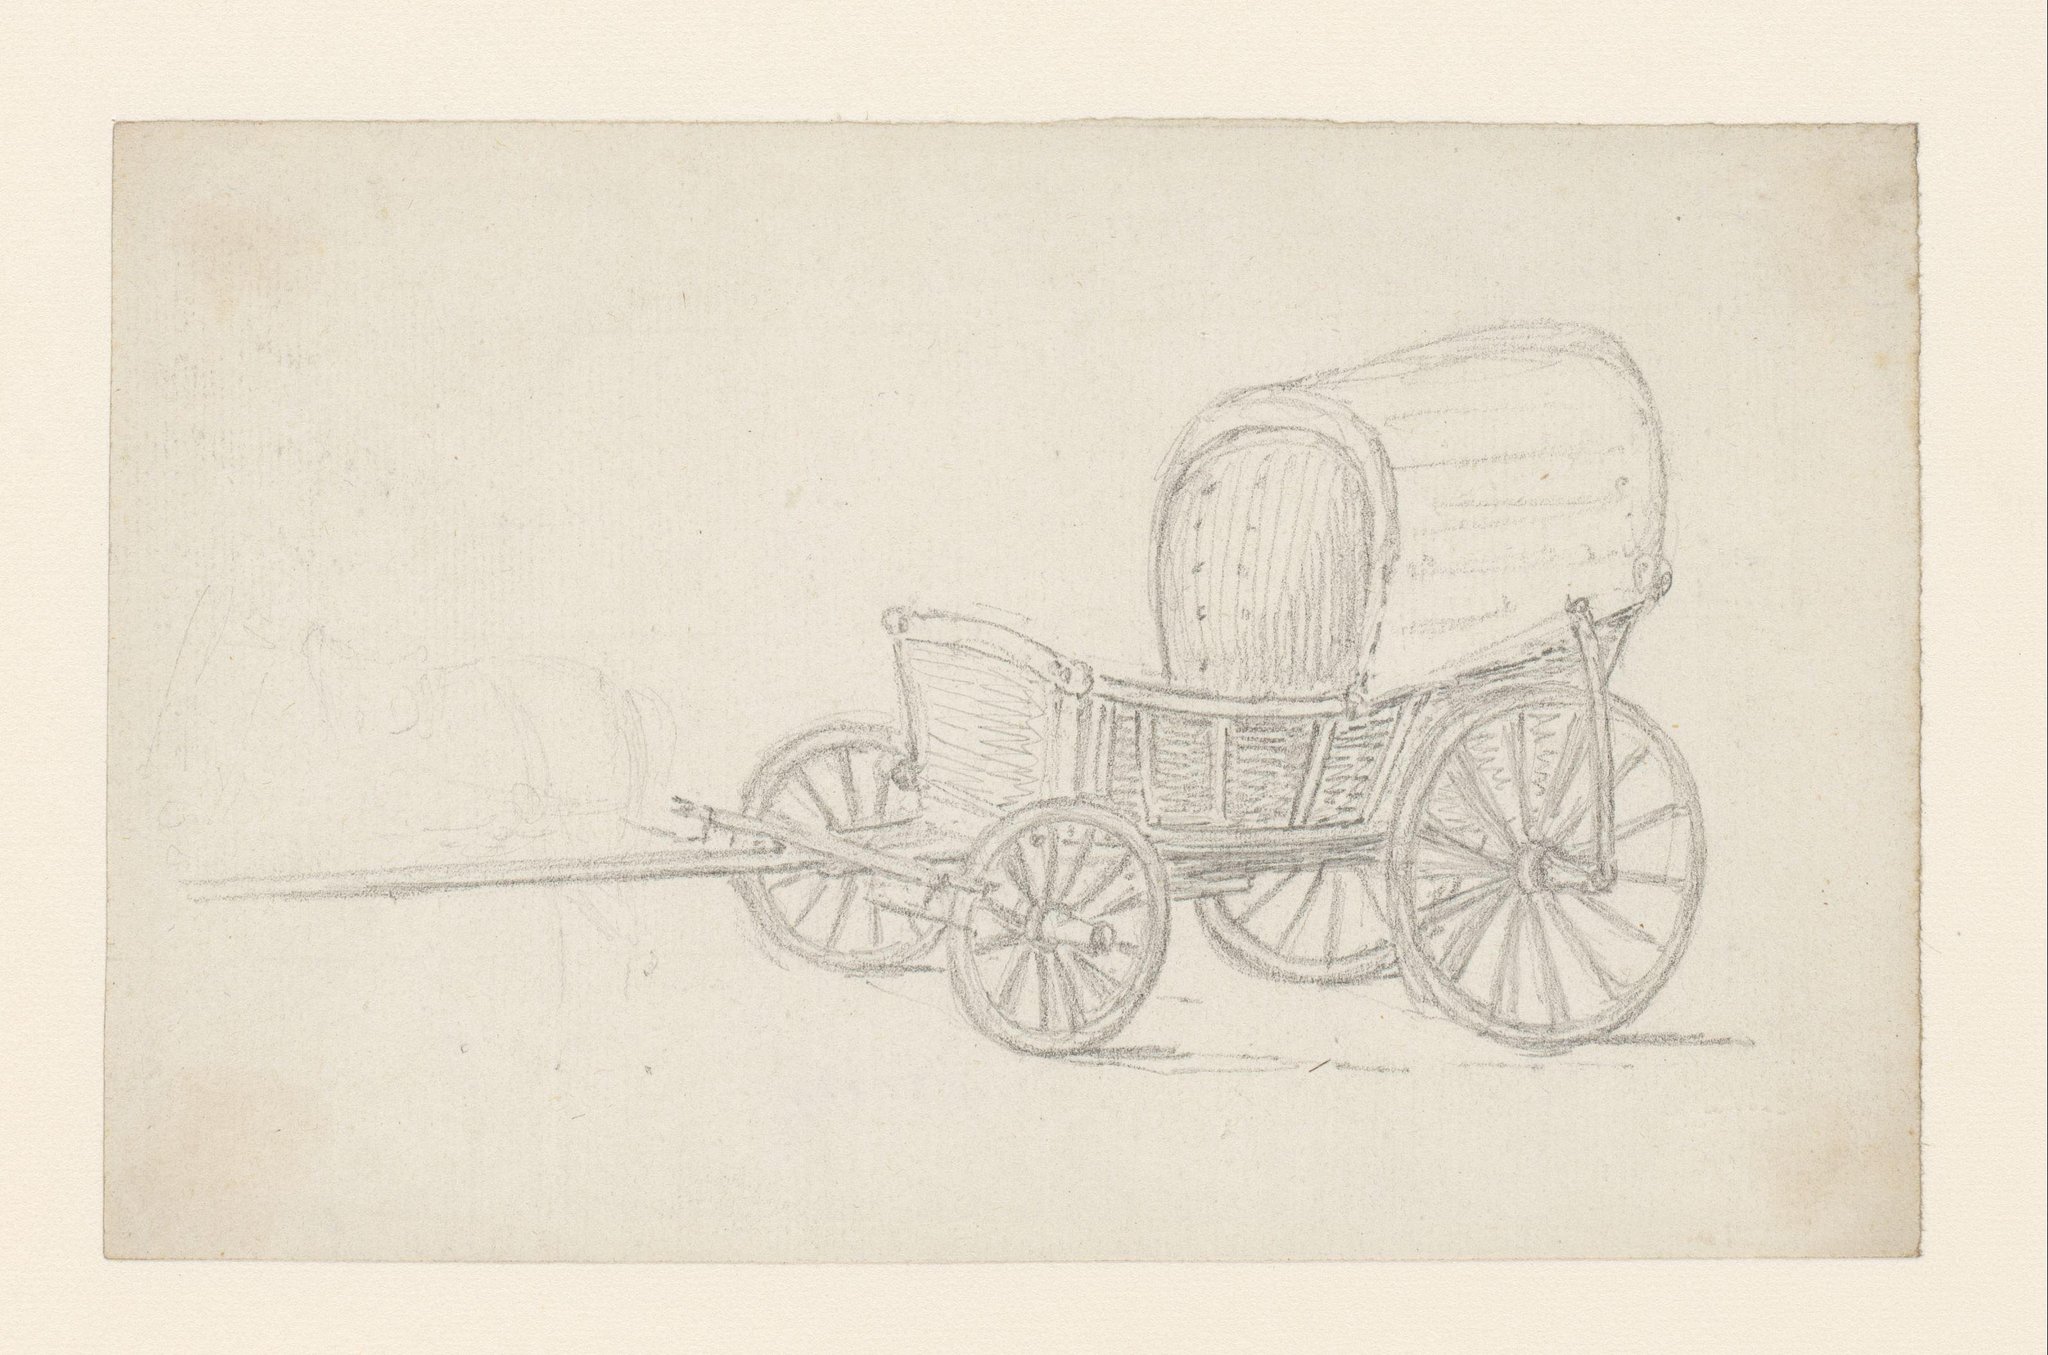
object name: drawing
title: Huifkar van tenen gevlochten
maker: georges michel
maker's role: draughtsman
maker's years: 1763-1843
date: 1773-1843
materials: paper, pencil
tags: covered wagon, hooded wagon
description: Een van 120 tekeningen, afkomstig uit een 19e eeuws album met tekeningen van Georges Michel.